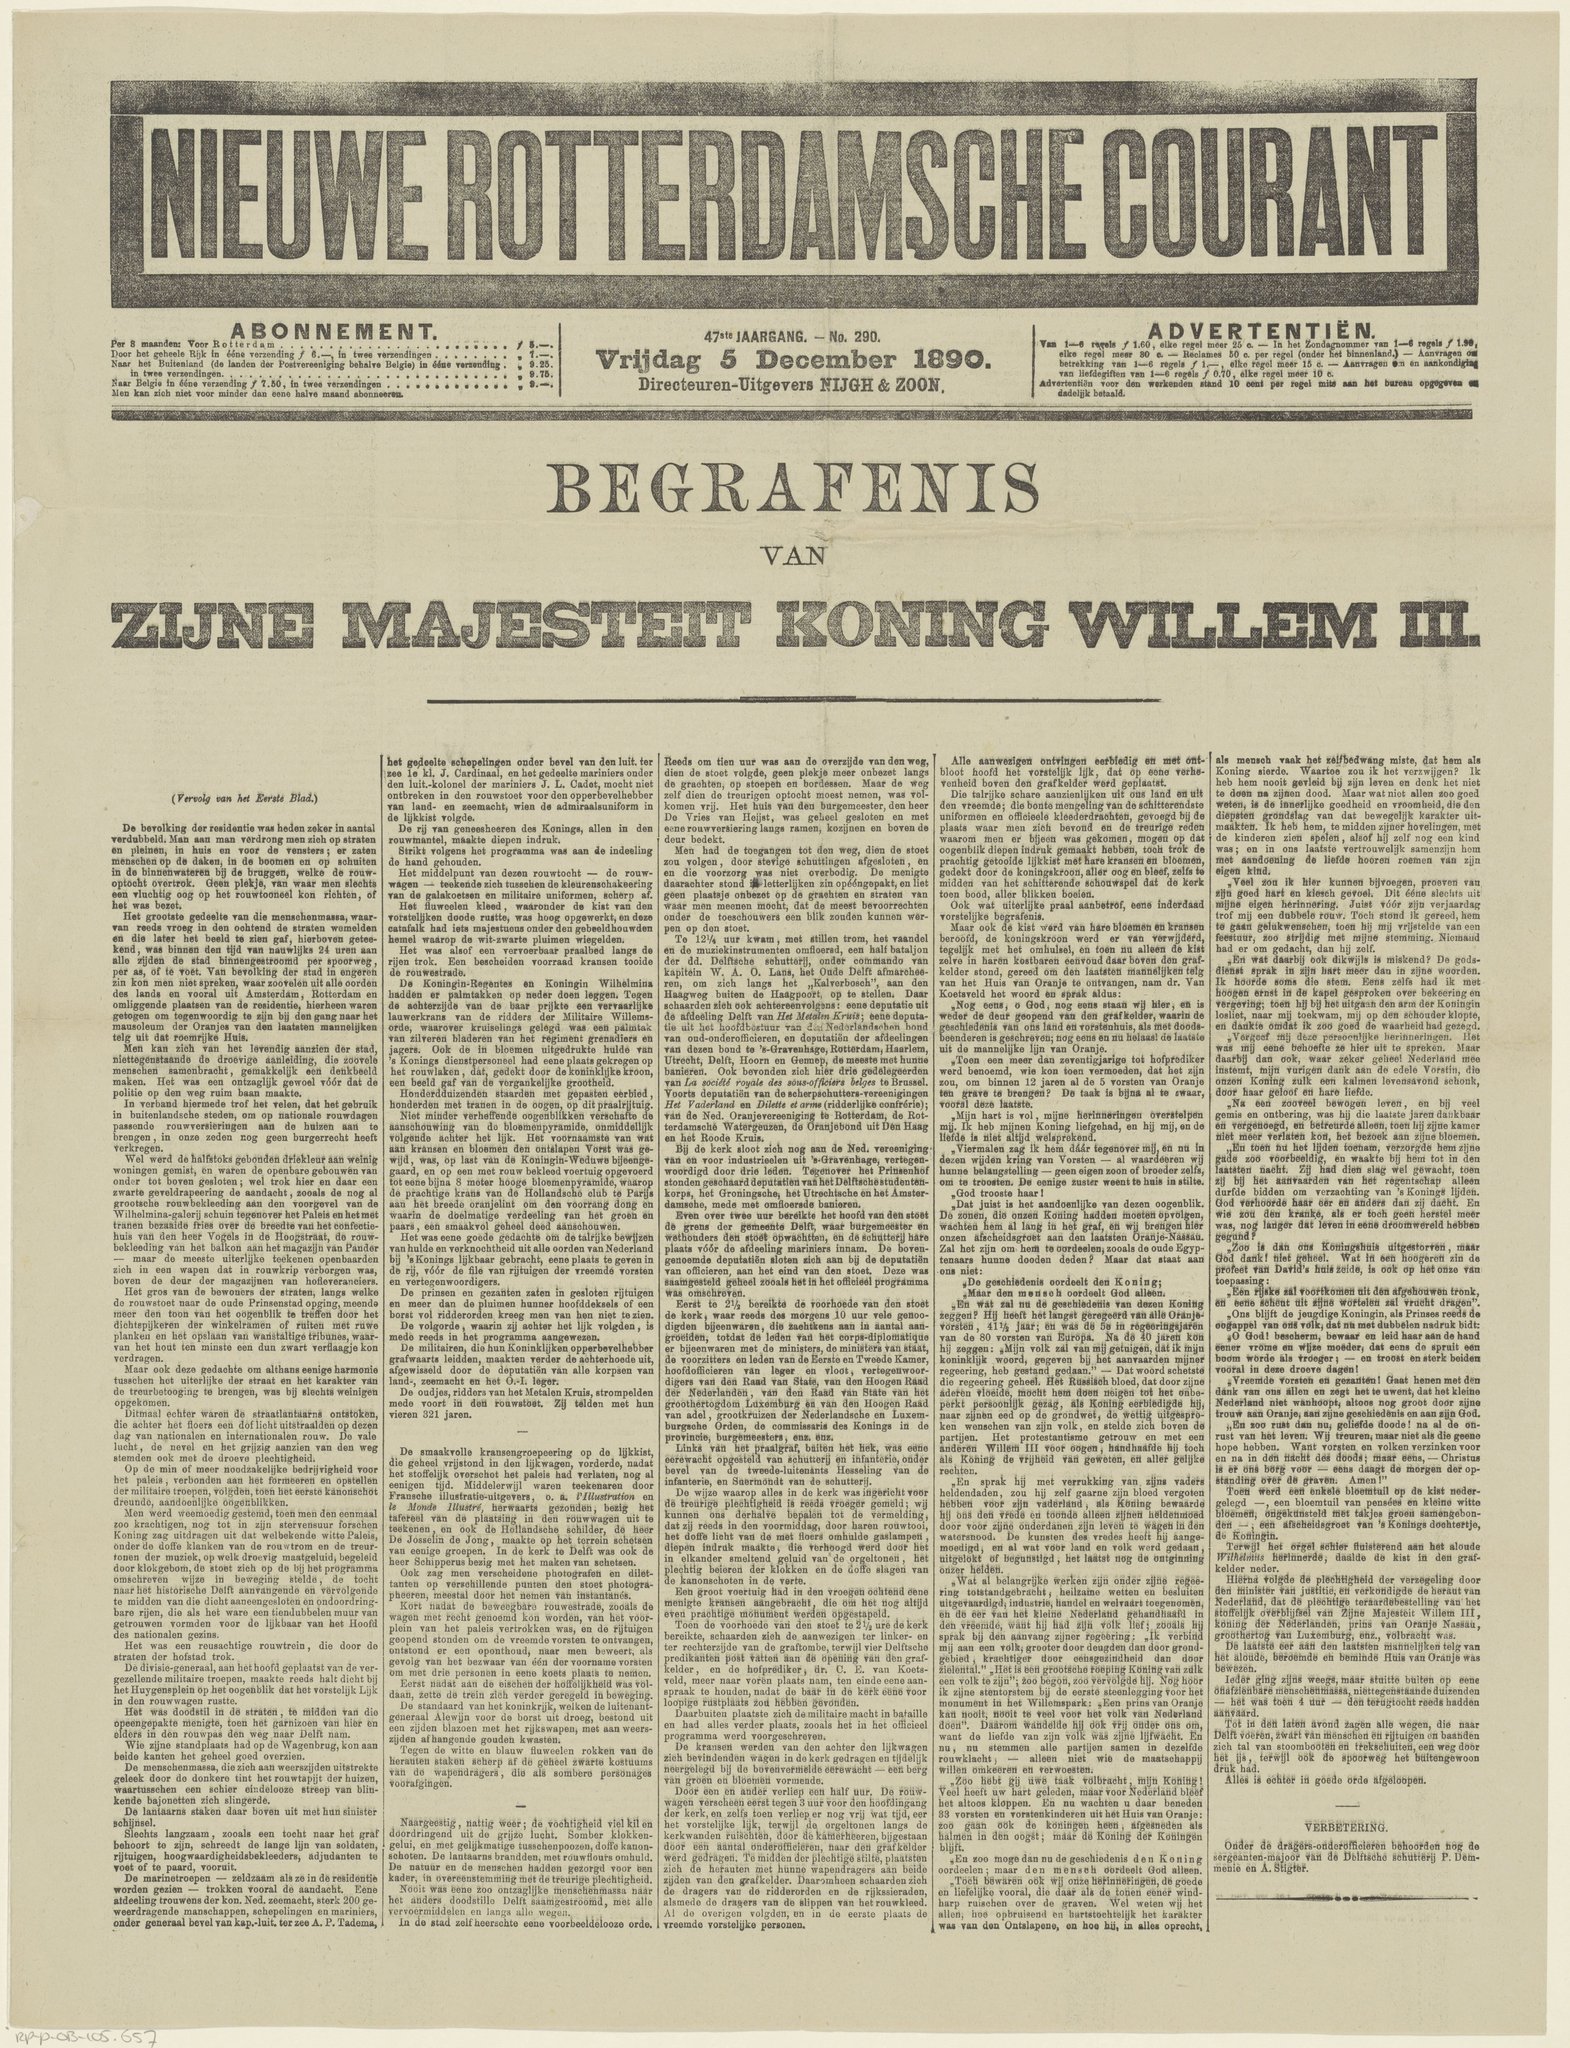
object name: newspaper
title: Krant met een artikel over de begrafenis van Willem III, koning der Nederlanden, op 4 december 1890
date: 1890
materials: paper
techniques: letterpress printing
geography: rotterdam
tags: willem iii (koning der nederlanden), funerary ceremonial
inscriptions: date